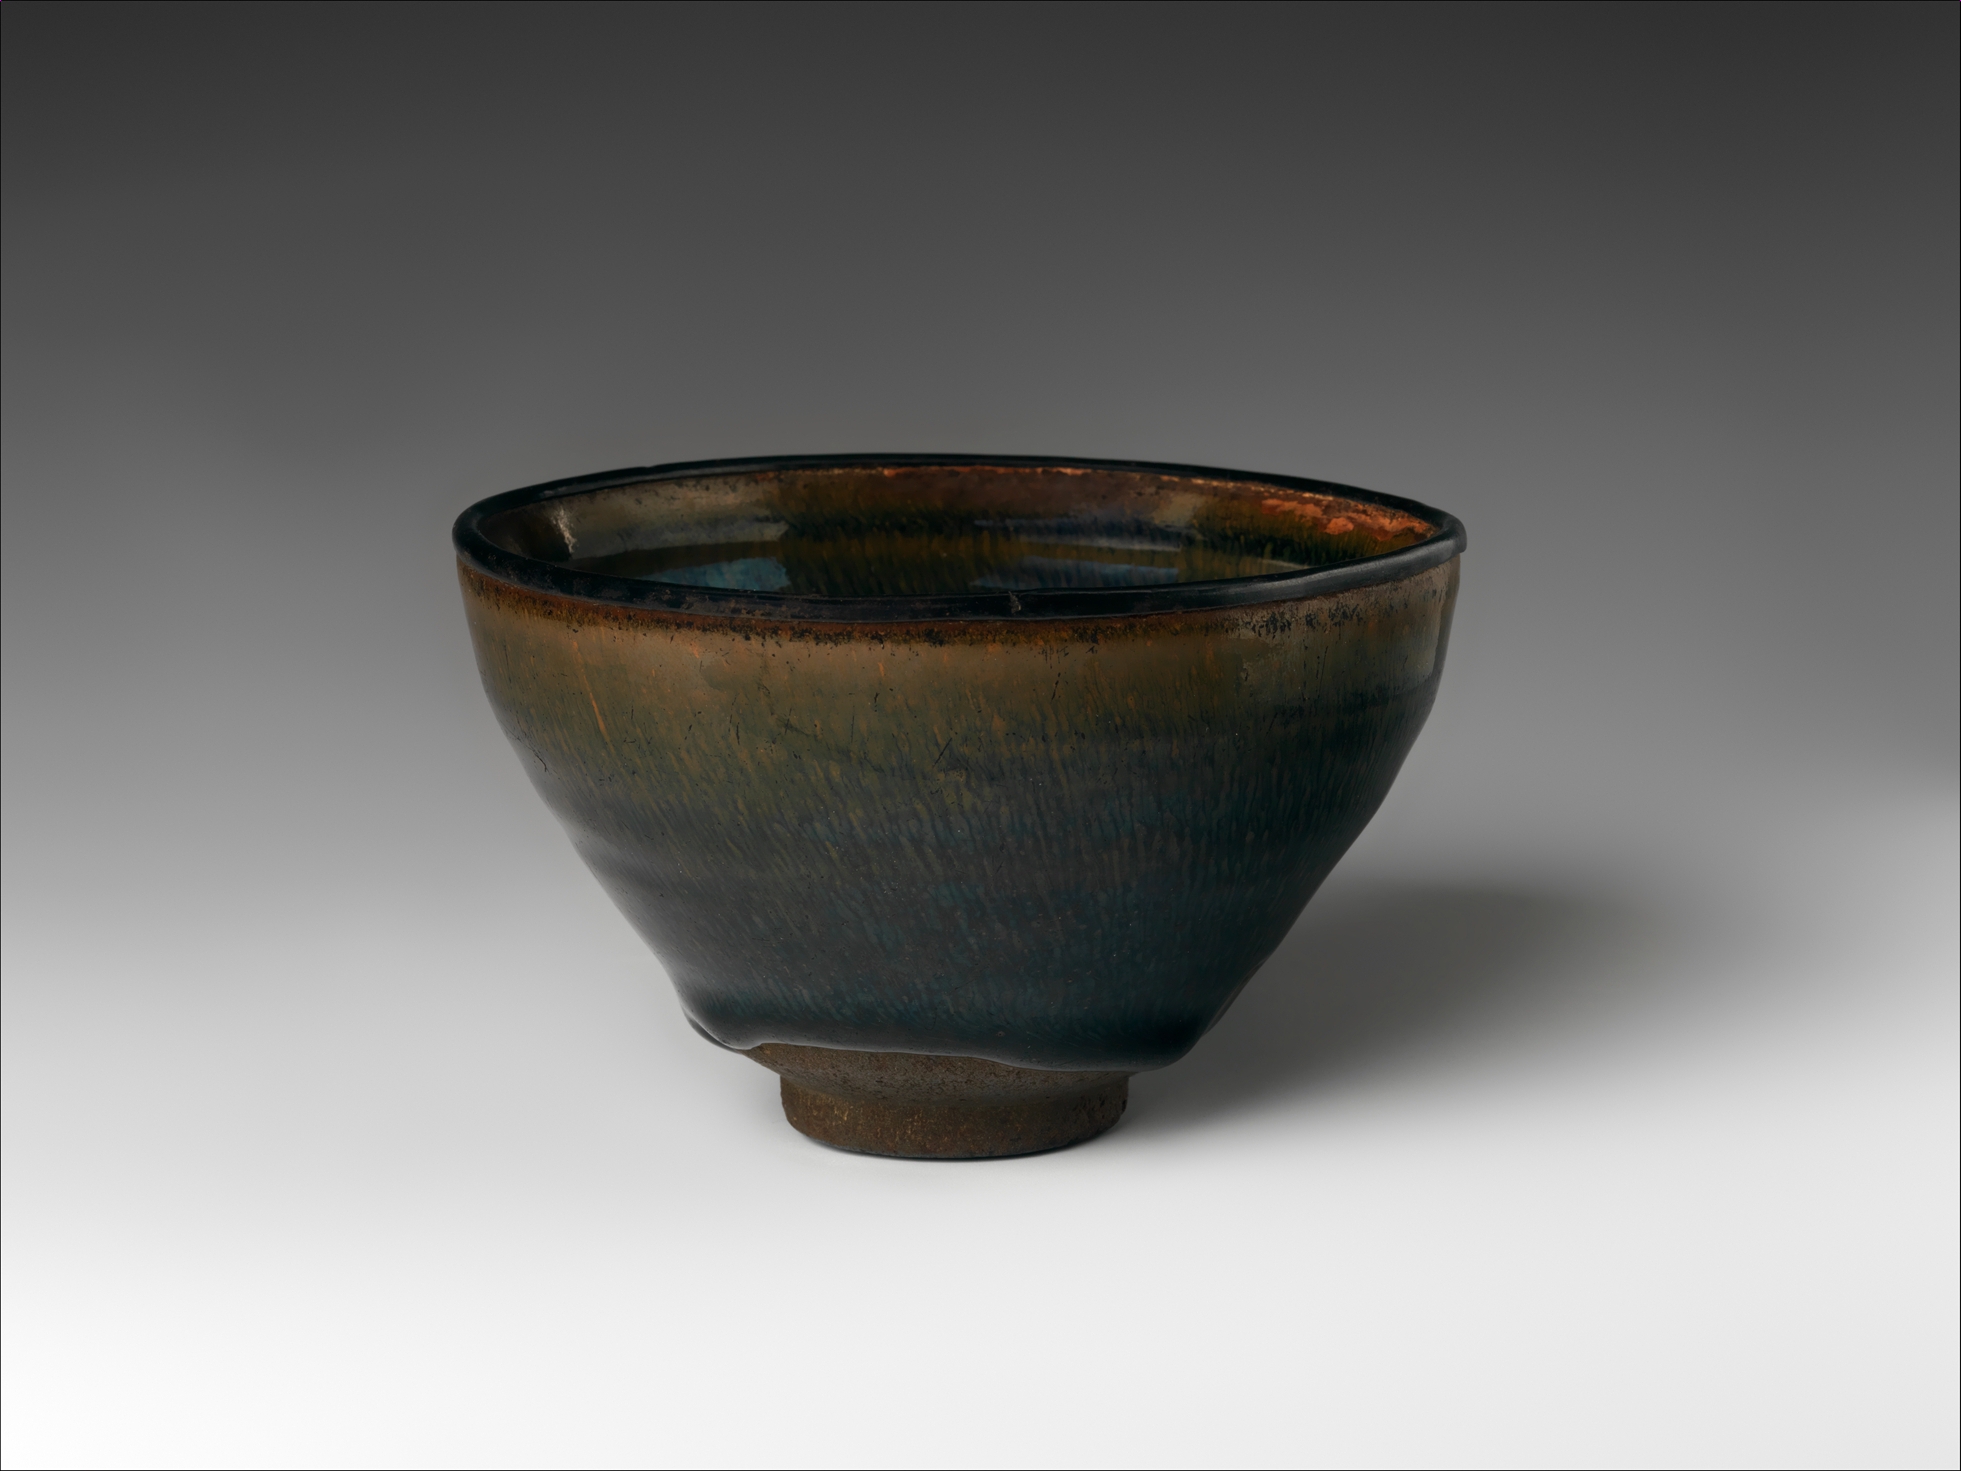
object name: bowl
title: Tea Bowl with Hare’s-Fur Decoration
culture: chinese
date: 1001-1200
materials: copper, glaze, stoneware